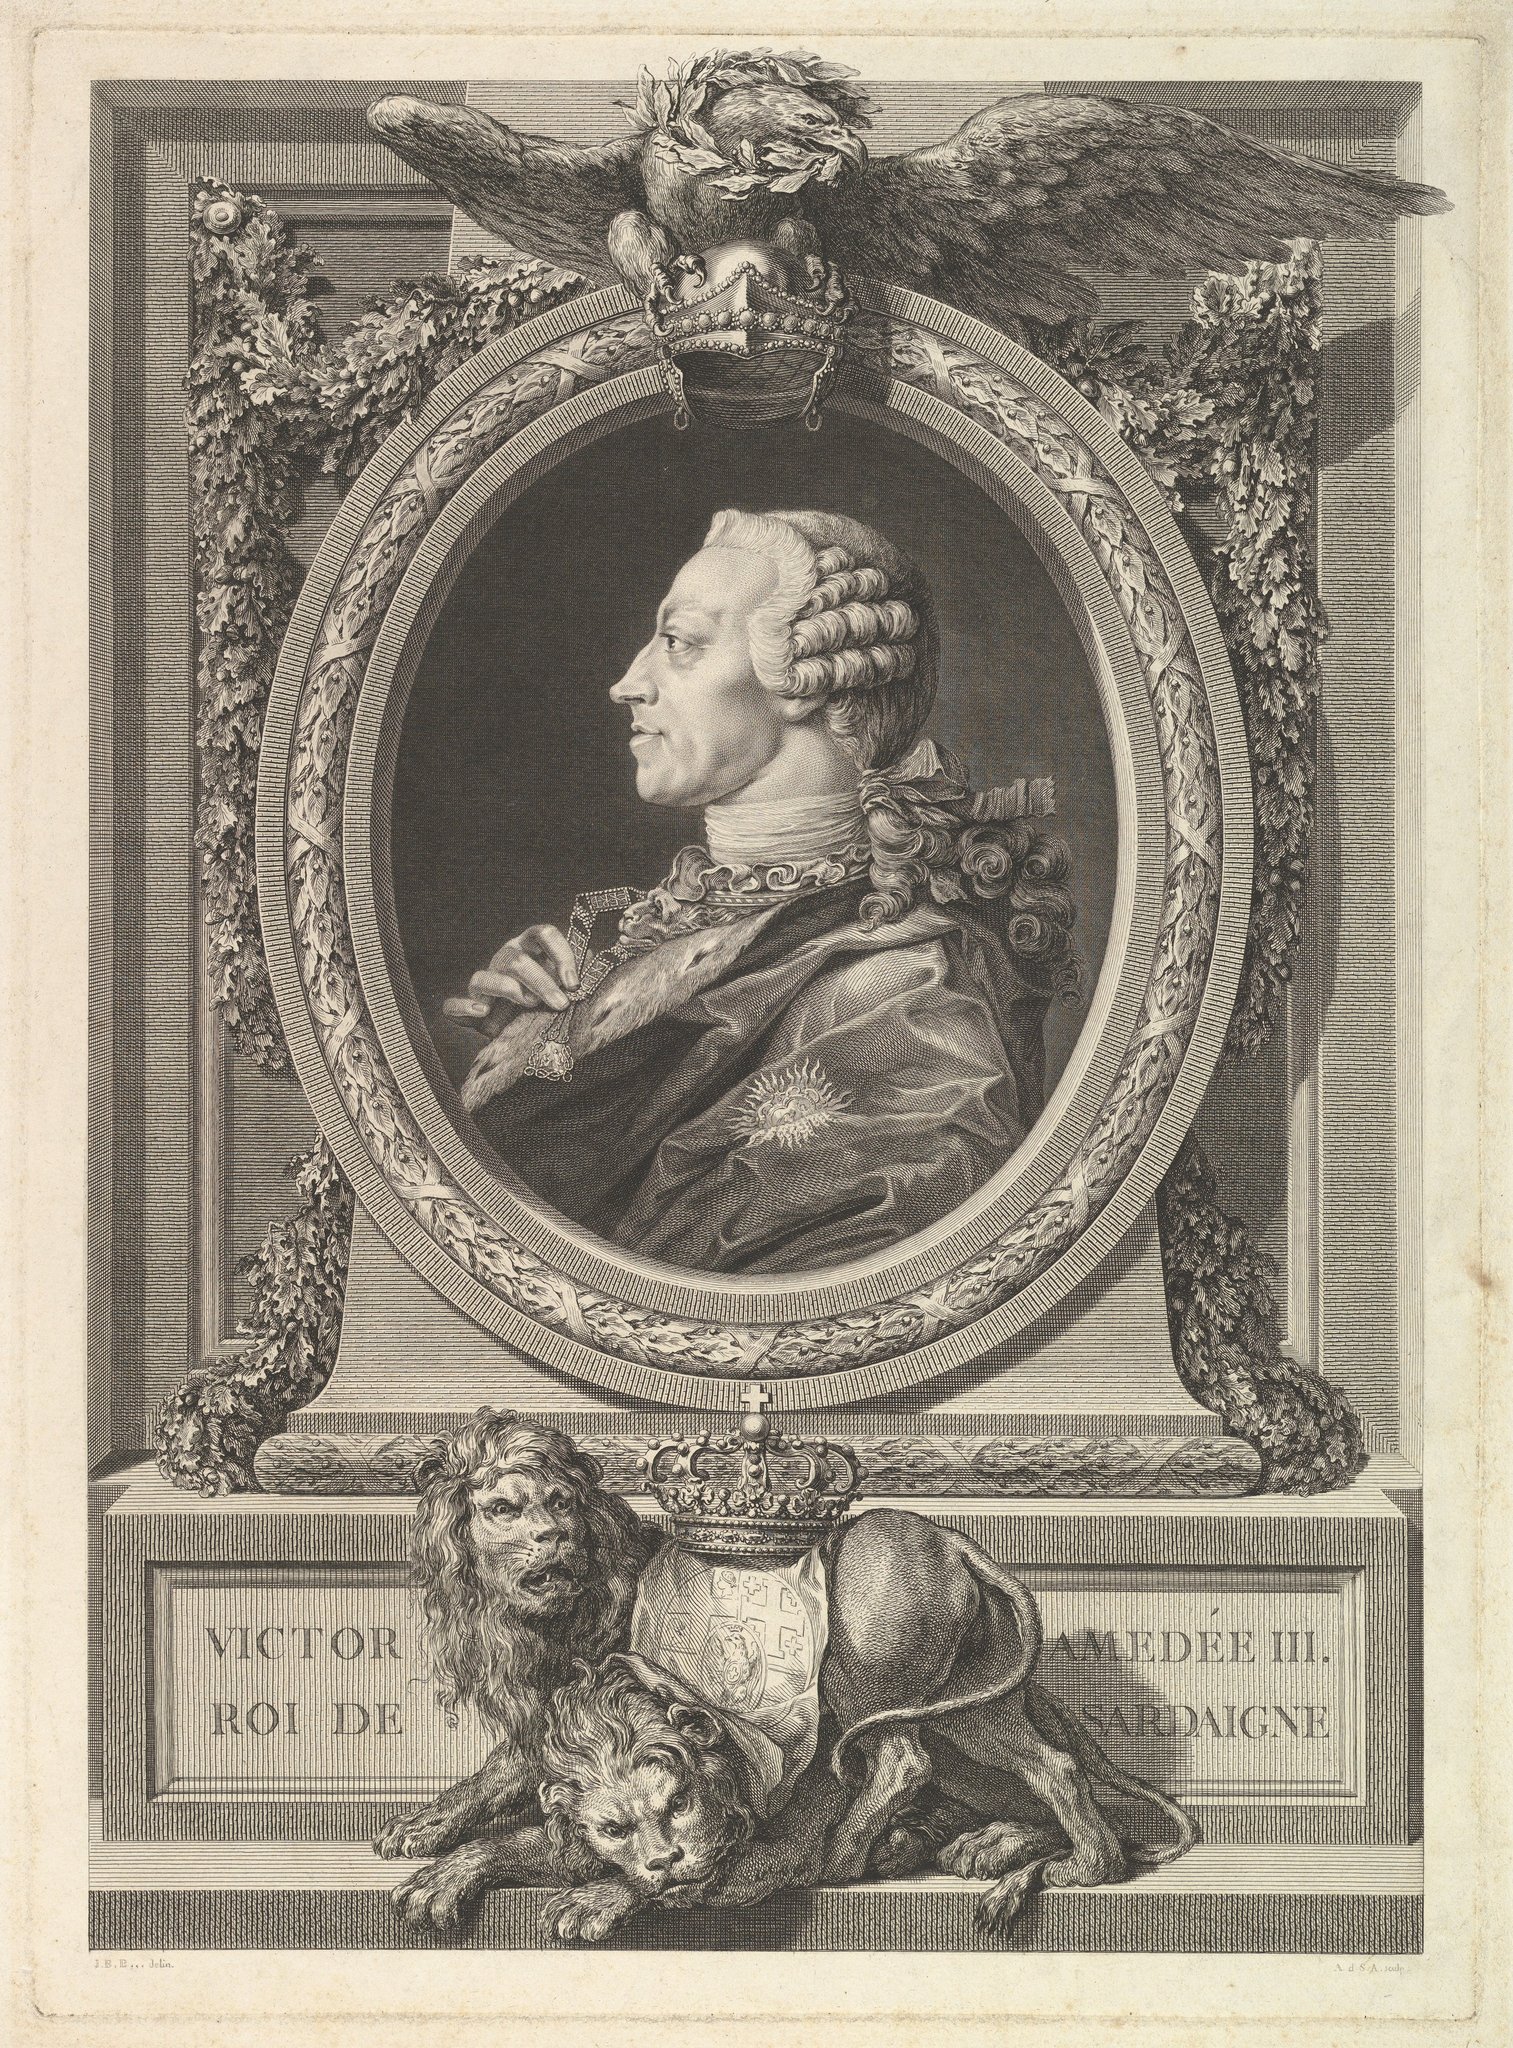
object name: print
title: Portrait of Victor Amadeus III, King of Sardinia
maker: augustin de saint-aubin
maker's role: artist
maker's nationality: french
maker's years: 1736-1807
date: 1777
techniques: engraving, etching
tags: eagles,kings,profiles,coat of arms